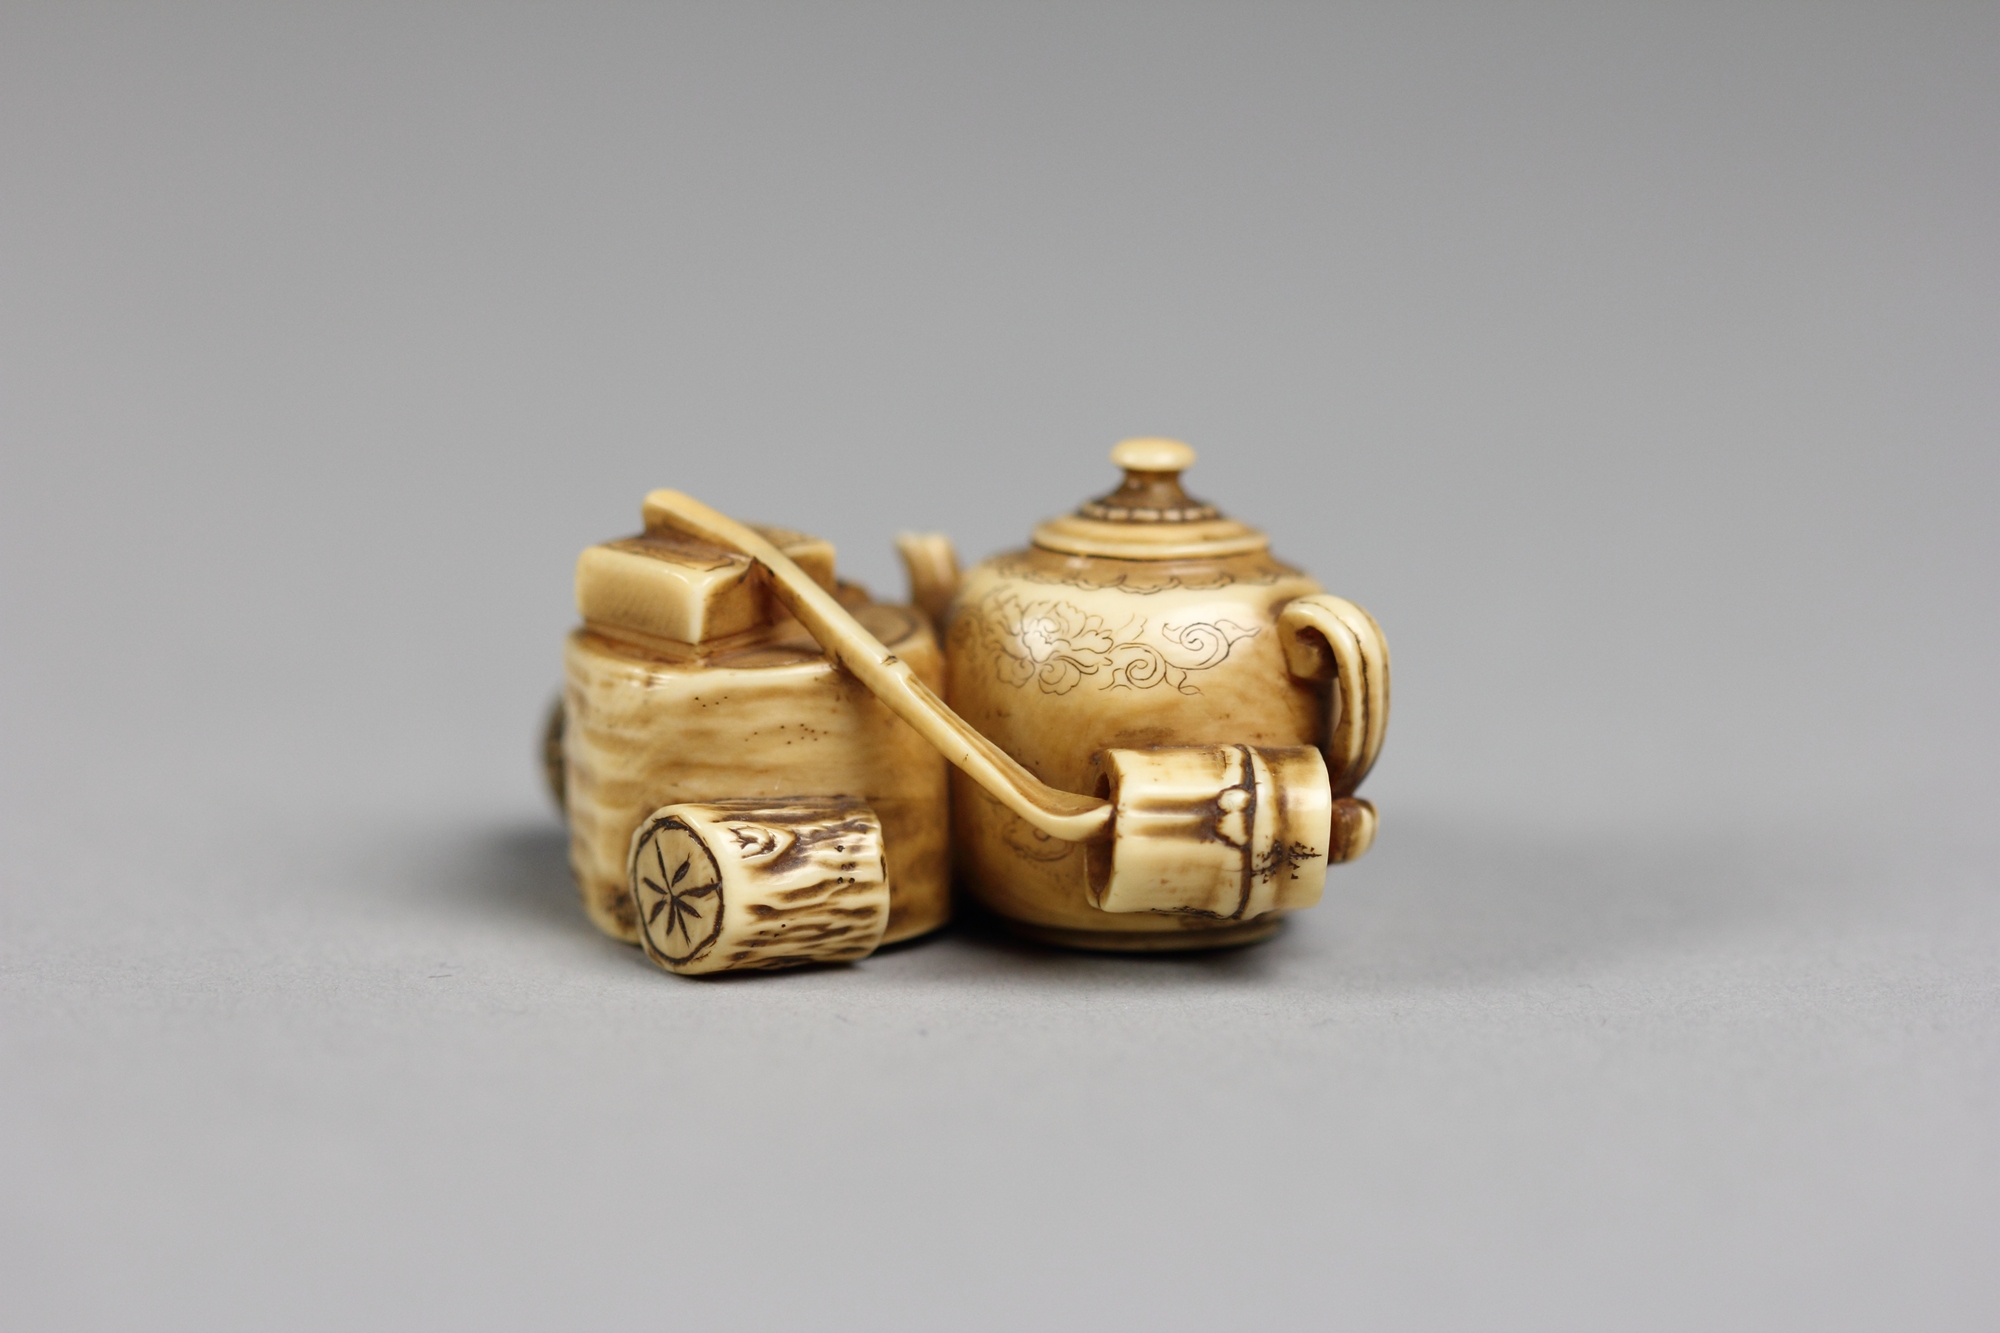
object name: netsuke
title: Tea Utensils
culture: japanese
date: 1851-1900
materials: ivory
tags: teapots